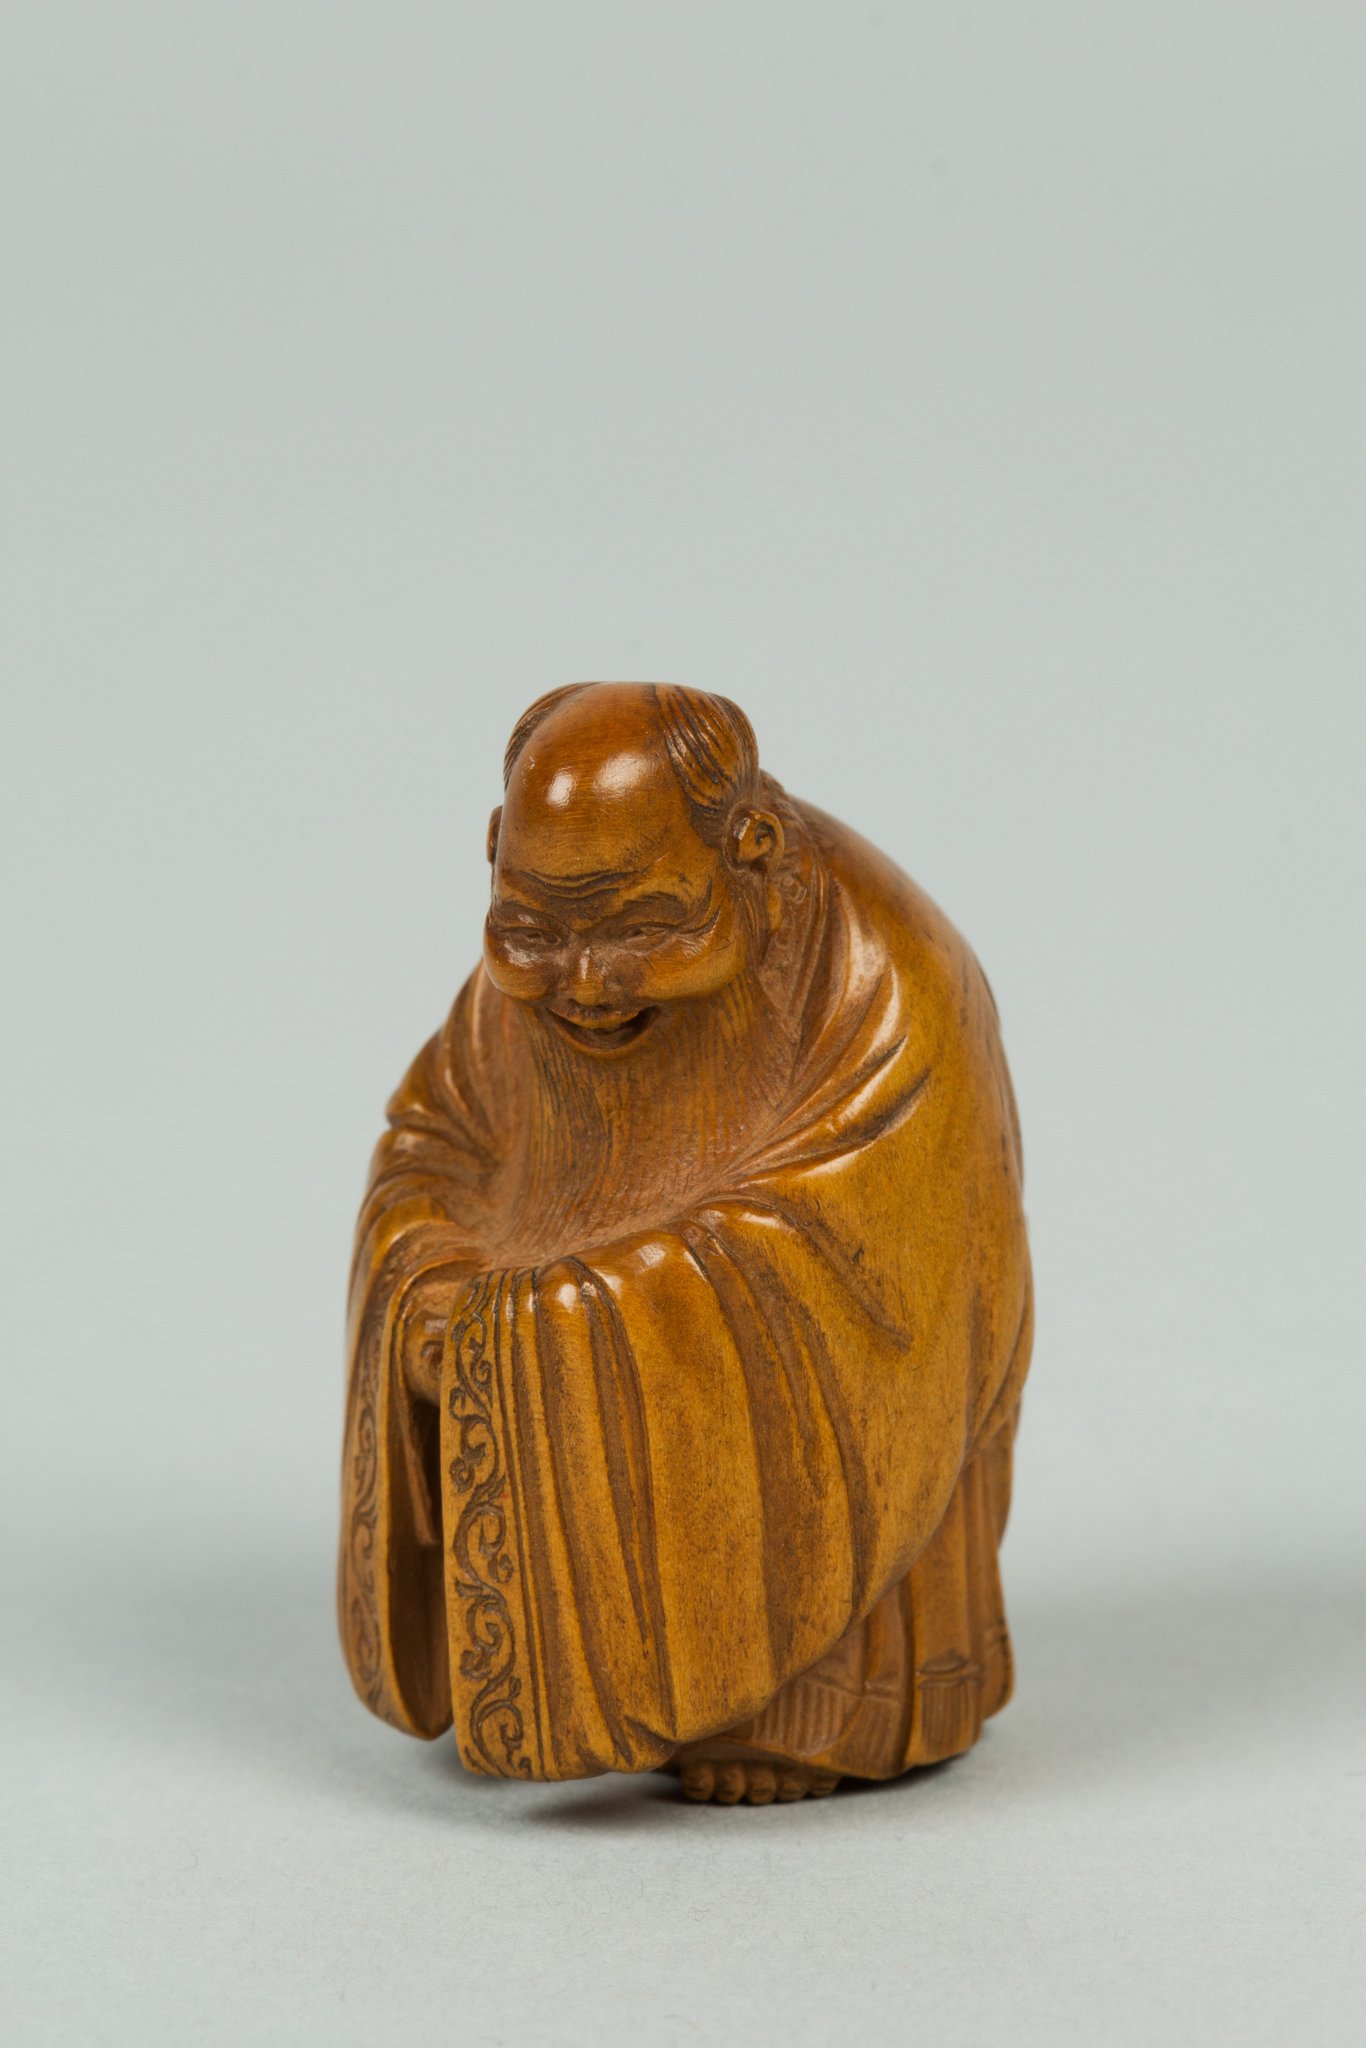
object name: netsuke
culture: japanese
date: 1767-1800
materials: wood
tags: men